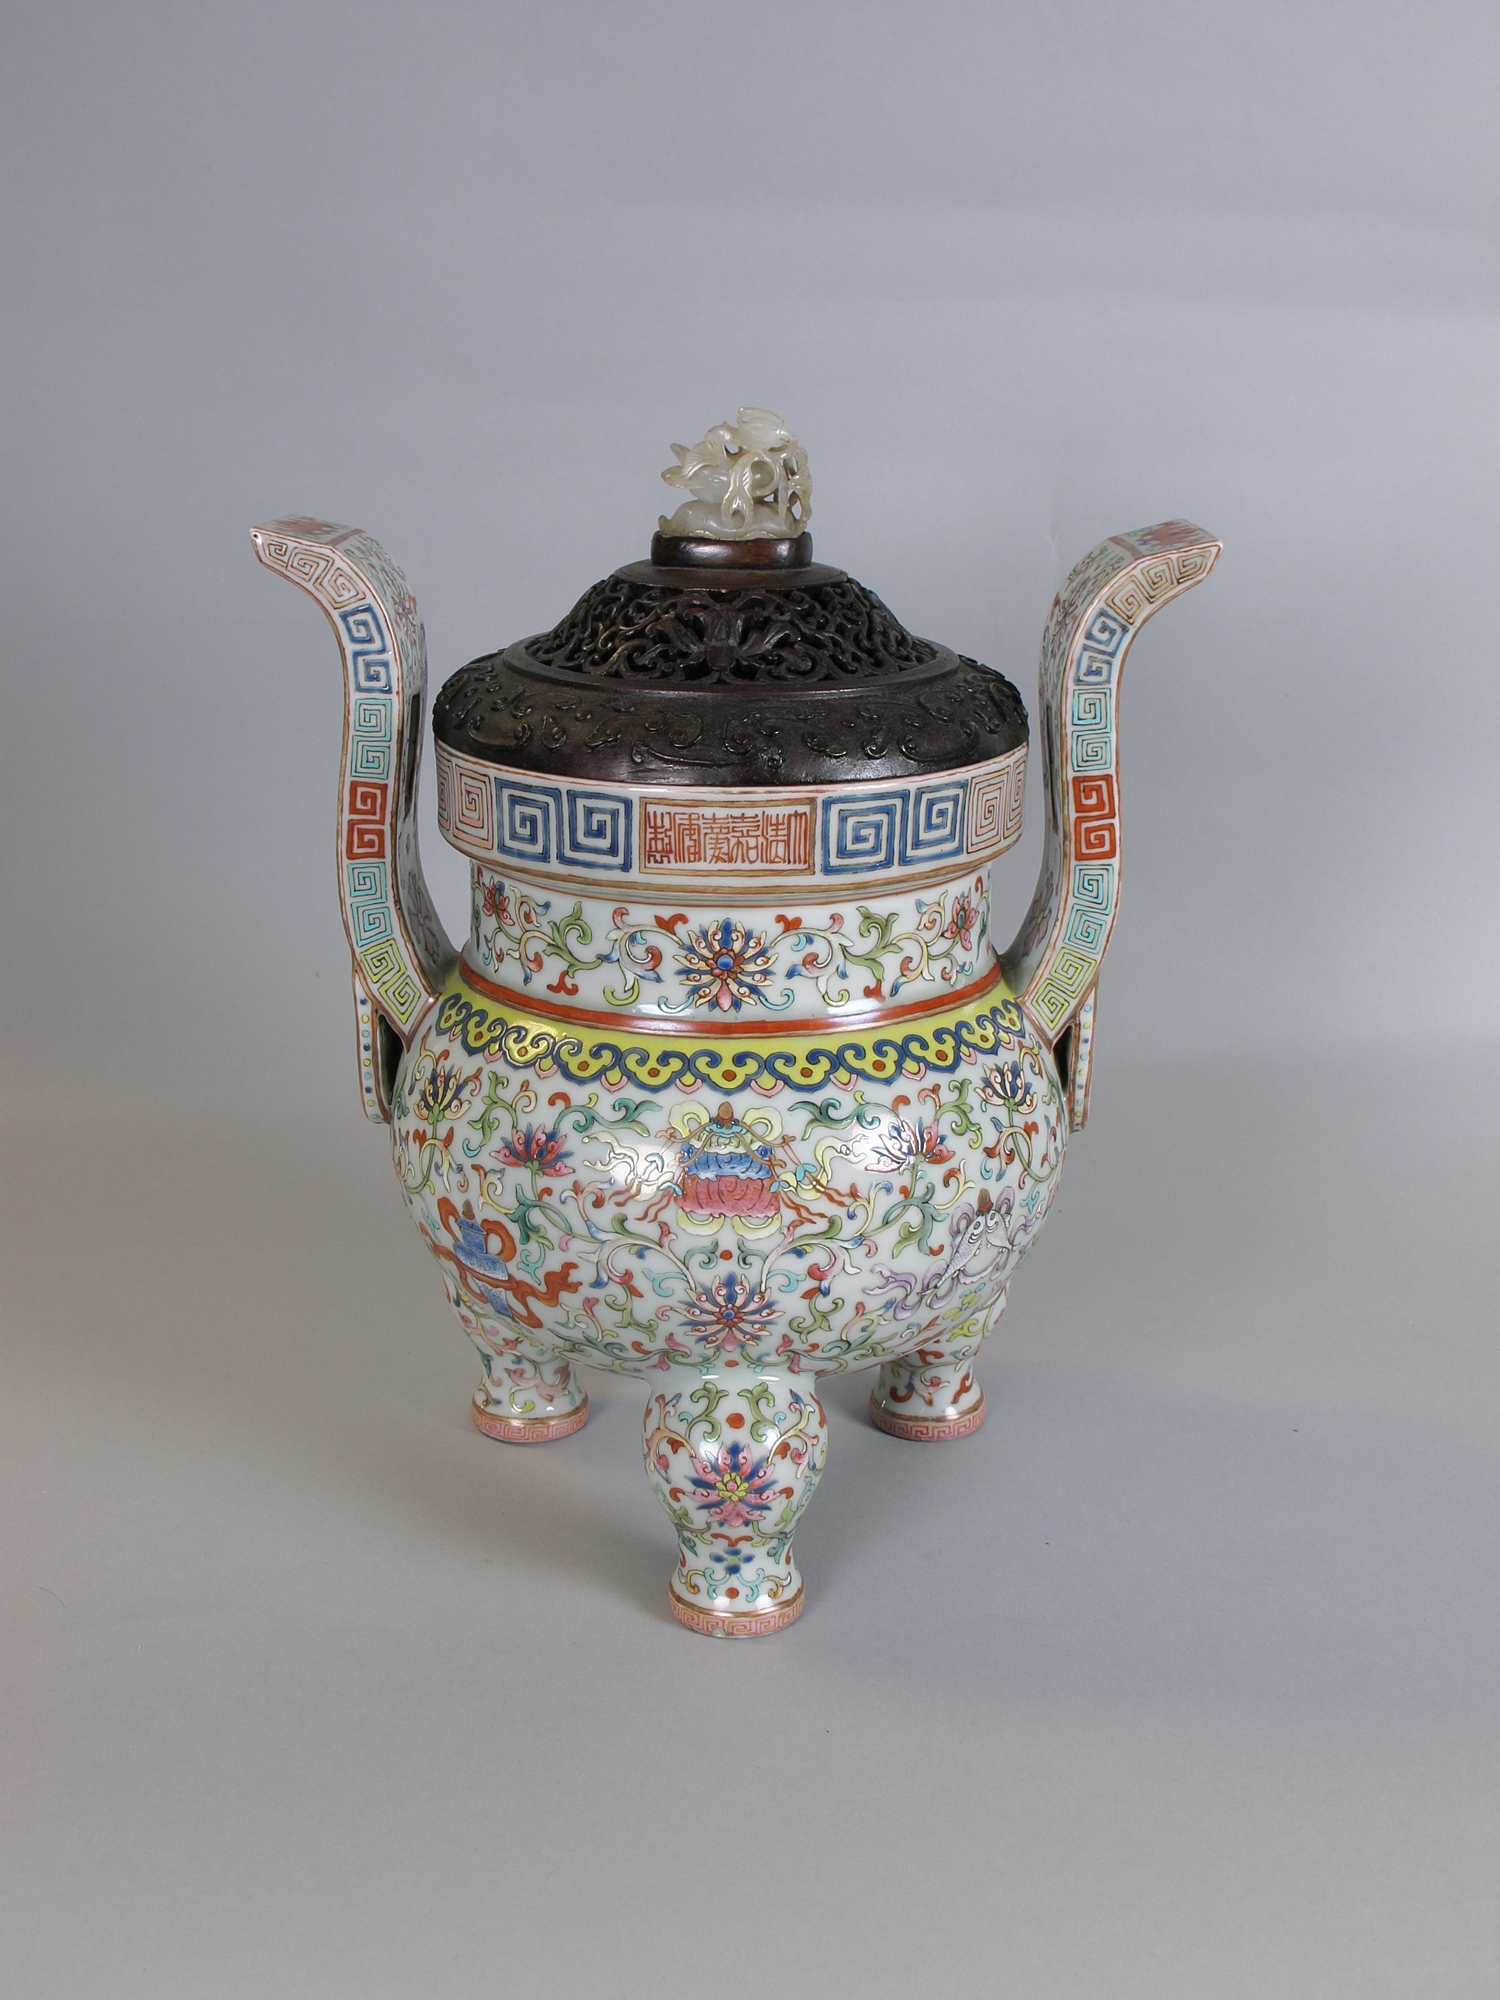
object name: incense burner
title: Tripod incense burner with Buddhist auspicious symbols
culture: chinese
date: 1767-1833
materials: enamel, jade, porcelain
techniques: overglaze, painting, polychrome